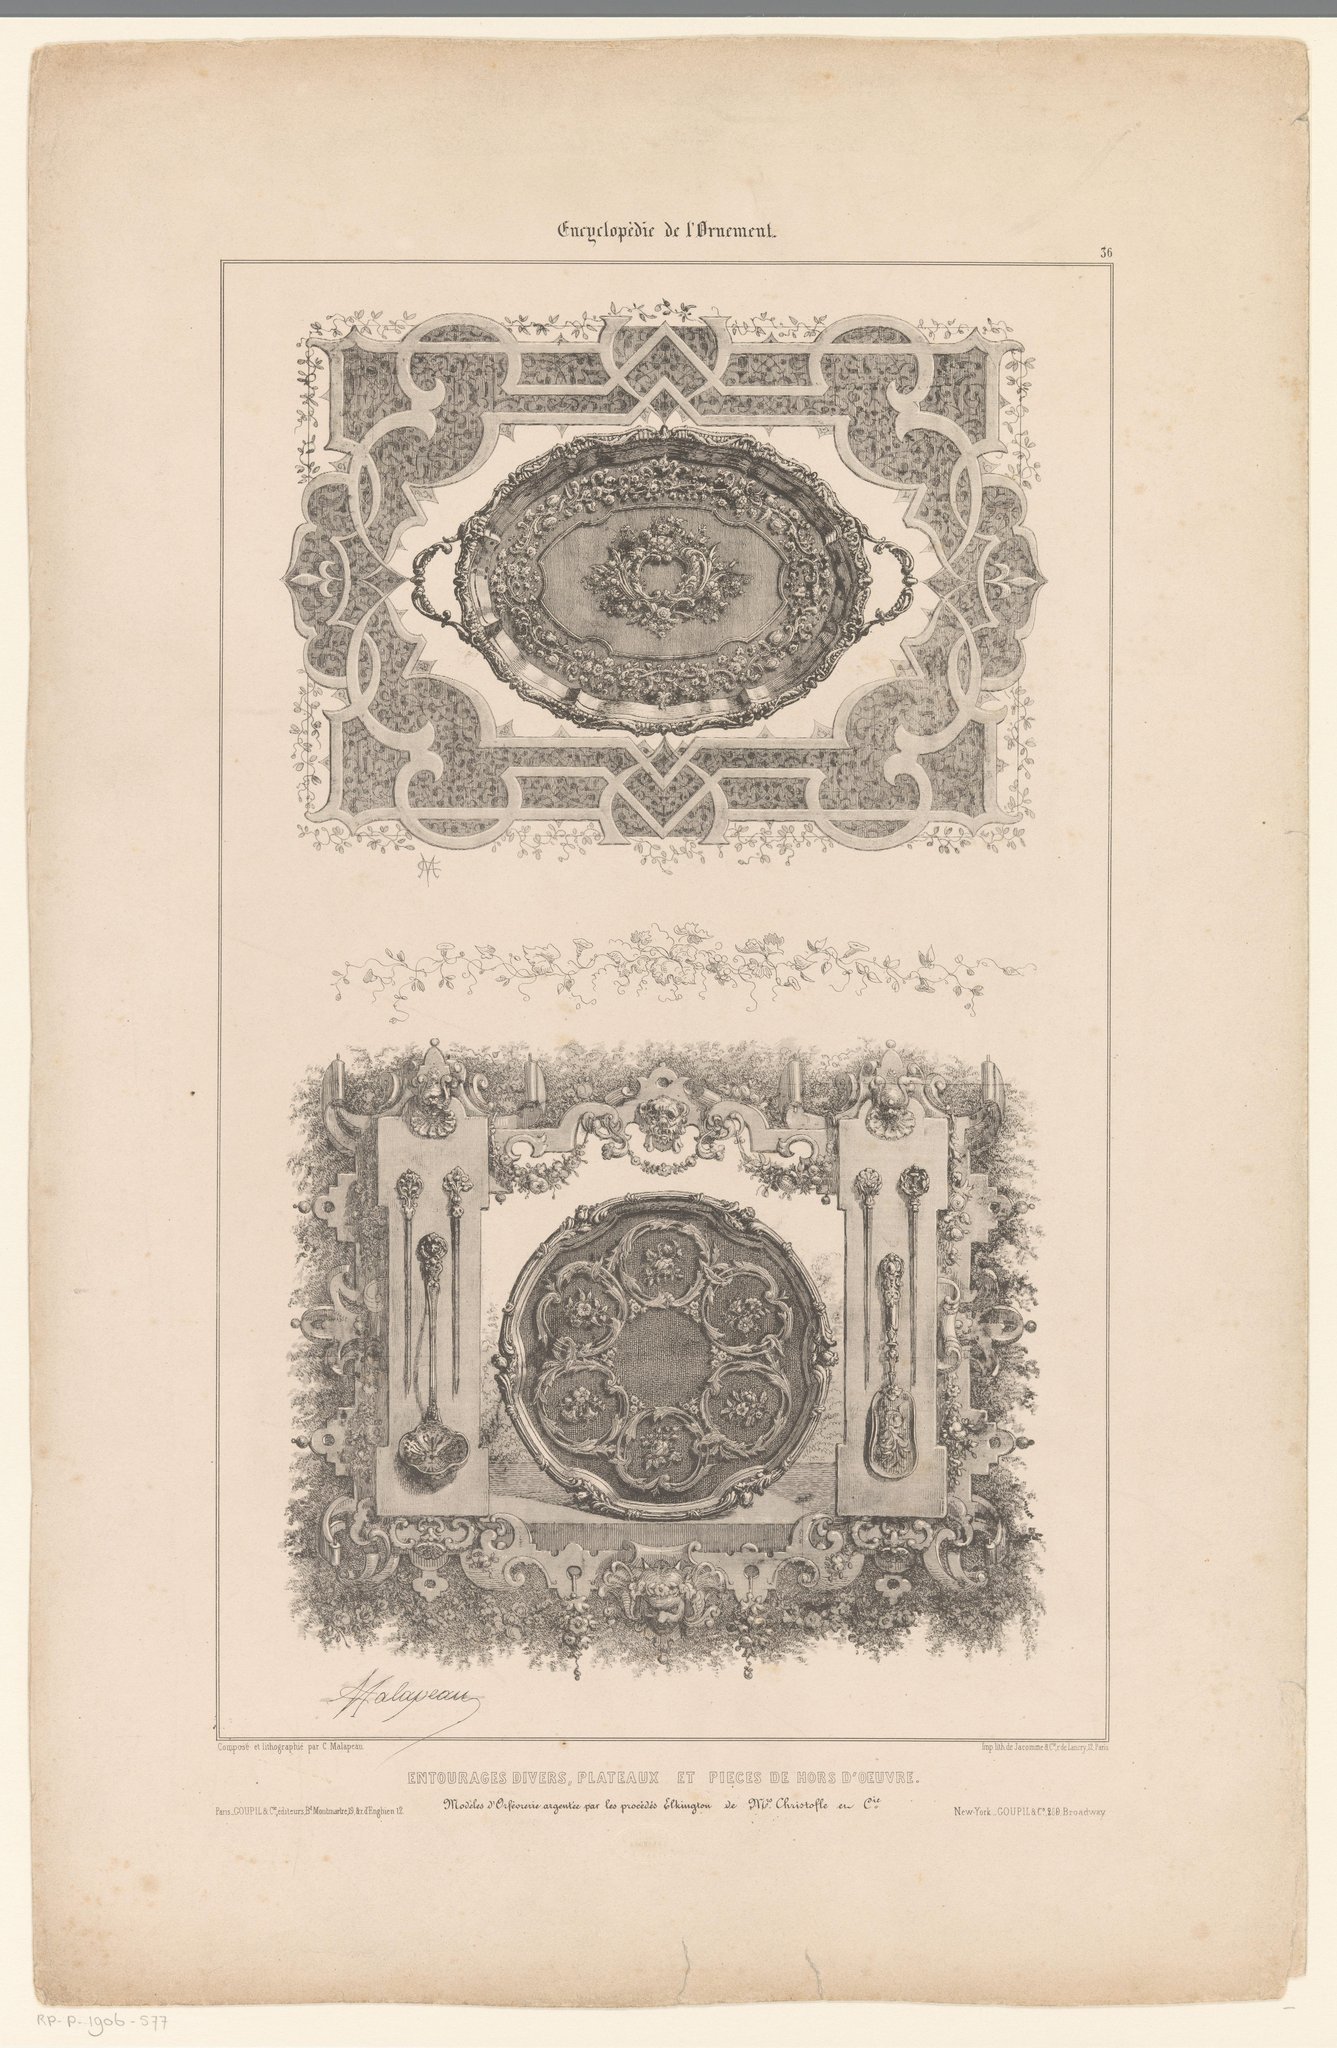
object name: print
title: Encyclopédie de l'Ornement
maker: claude nicolas malapeau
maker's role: print maker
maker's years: 1755-1803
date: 1850-1860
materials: paper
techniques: lithograph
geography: paris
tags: serving-dish, platter, table-ware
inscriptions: collector's mark: Lugt 2228, check stamp: ‘Goupil, Vibert & C / Editeurs / A Paris’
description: Aan de bovenzijde een ovale geornamenteerde schaal met twee oren in een ornamentele omlijsting. Daaronder een ronde geornamenteerde schaal en zes stuks hors d'oeuvre-bestek in een ornamentele omlijsting.